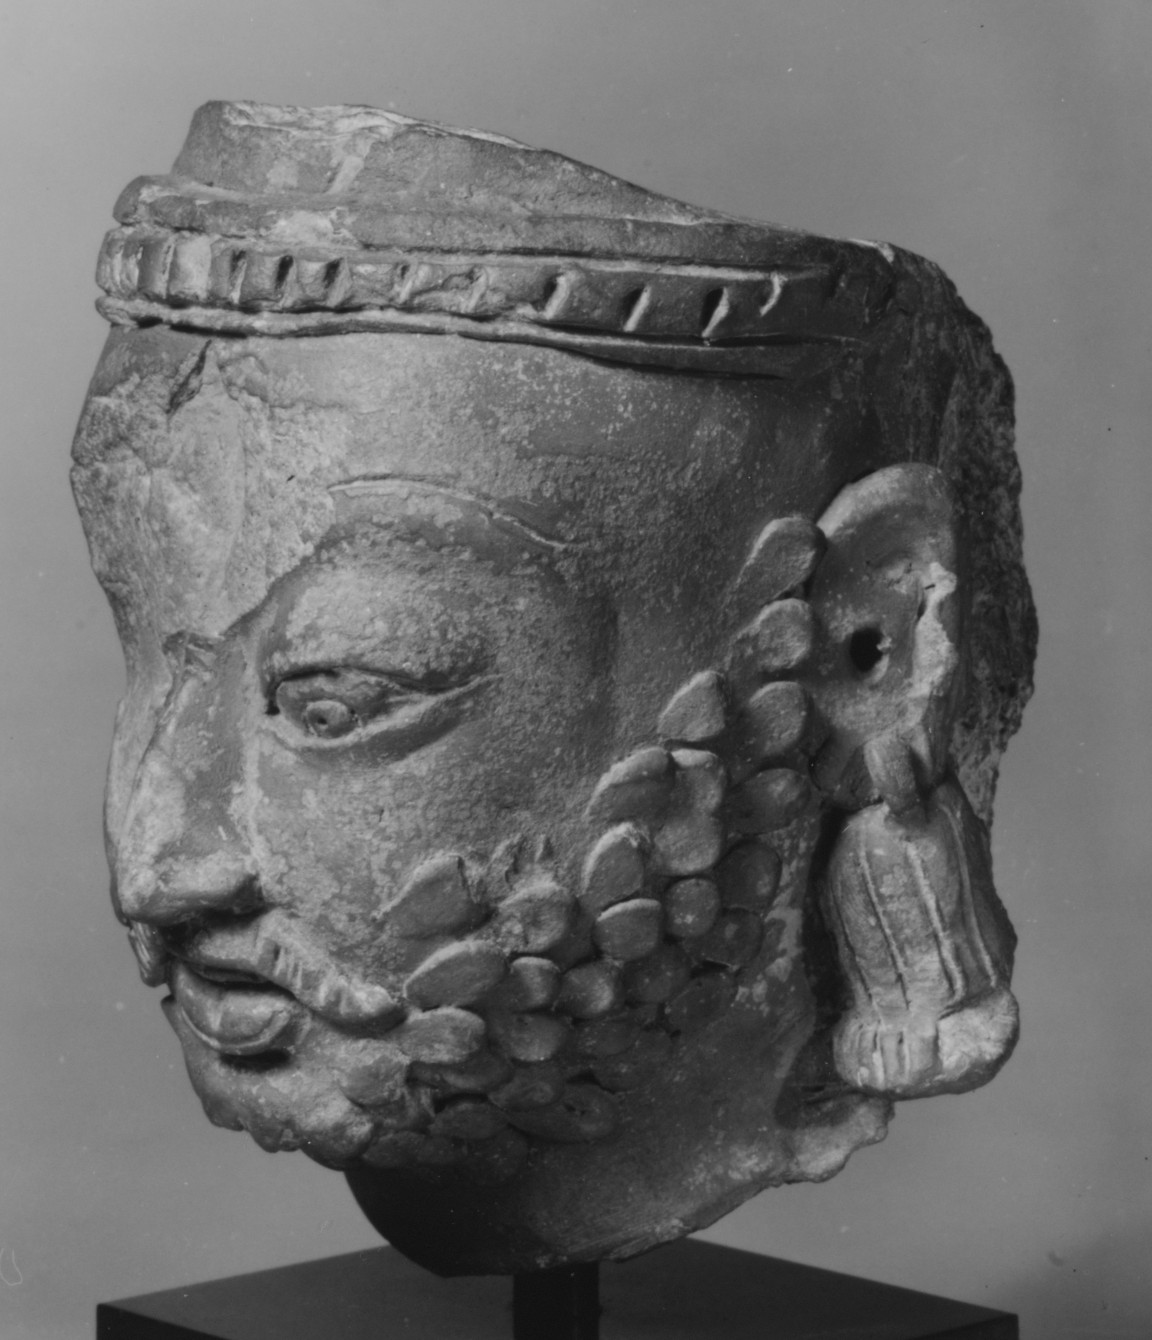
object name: head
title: Head of Garuda (The Royal Solar Bird)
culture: indian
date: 401-600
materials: terracotta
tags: birds,gupta,heads